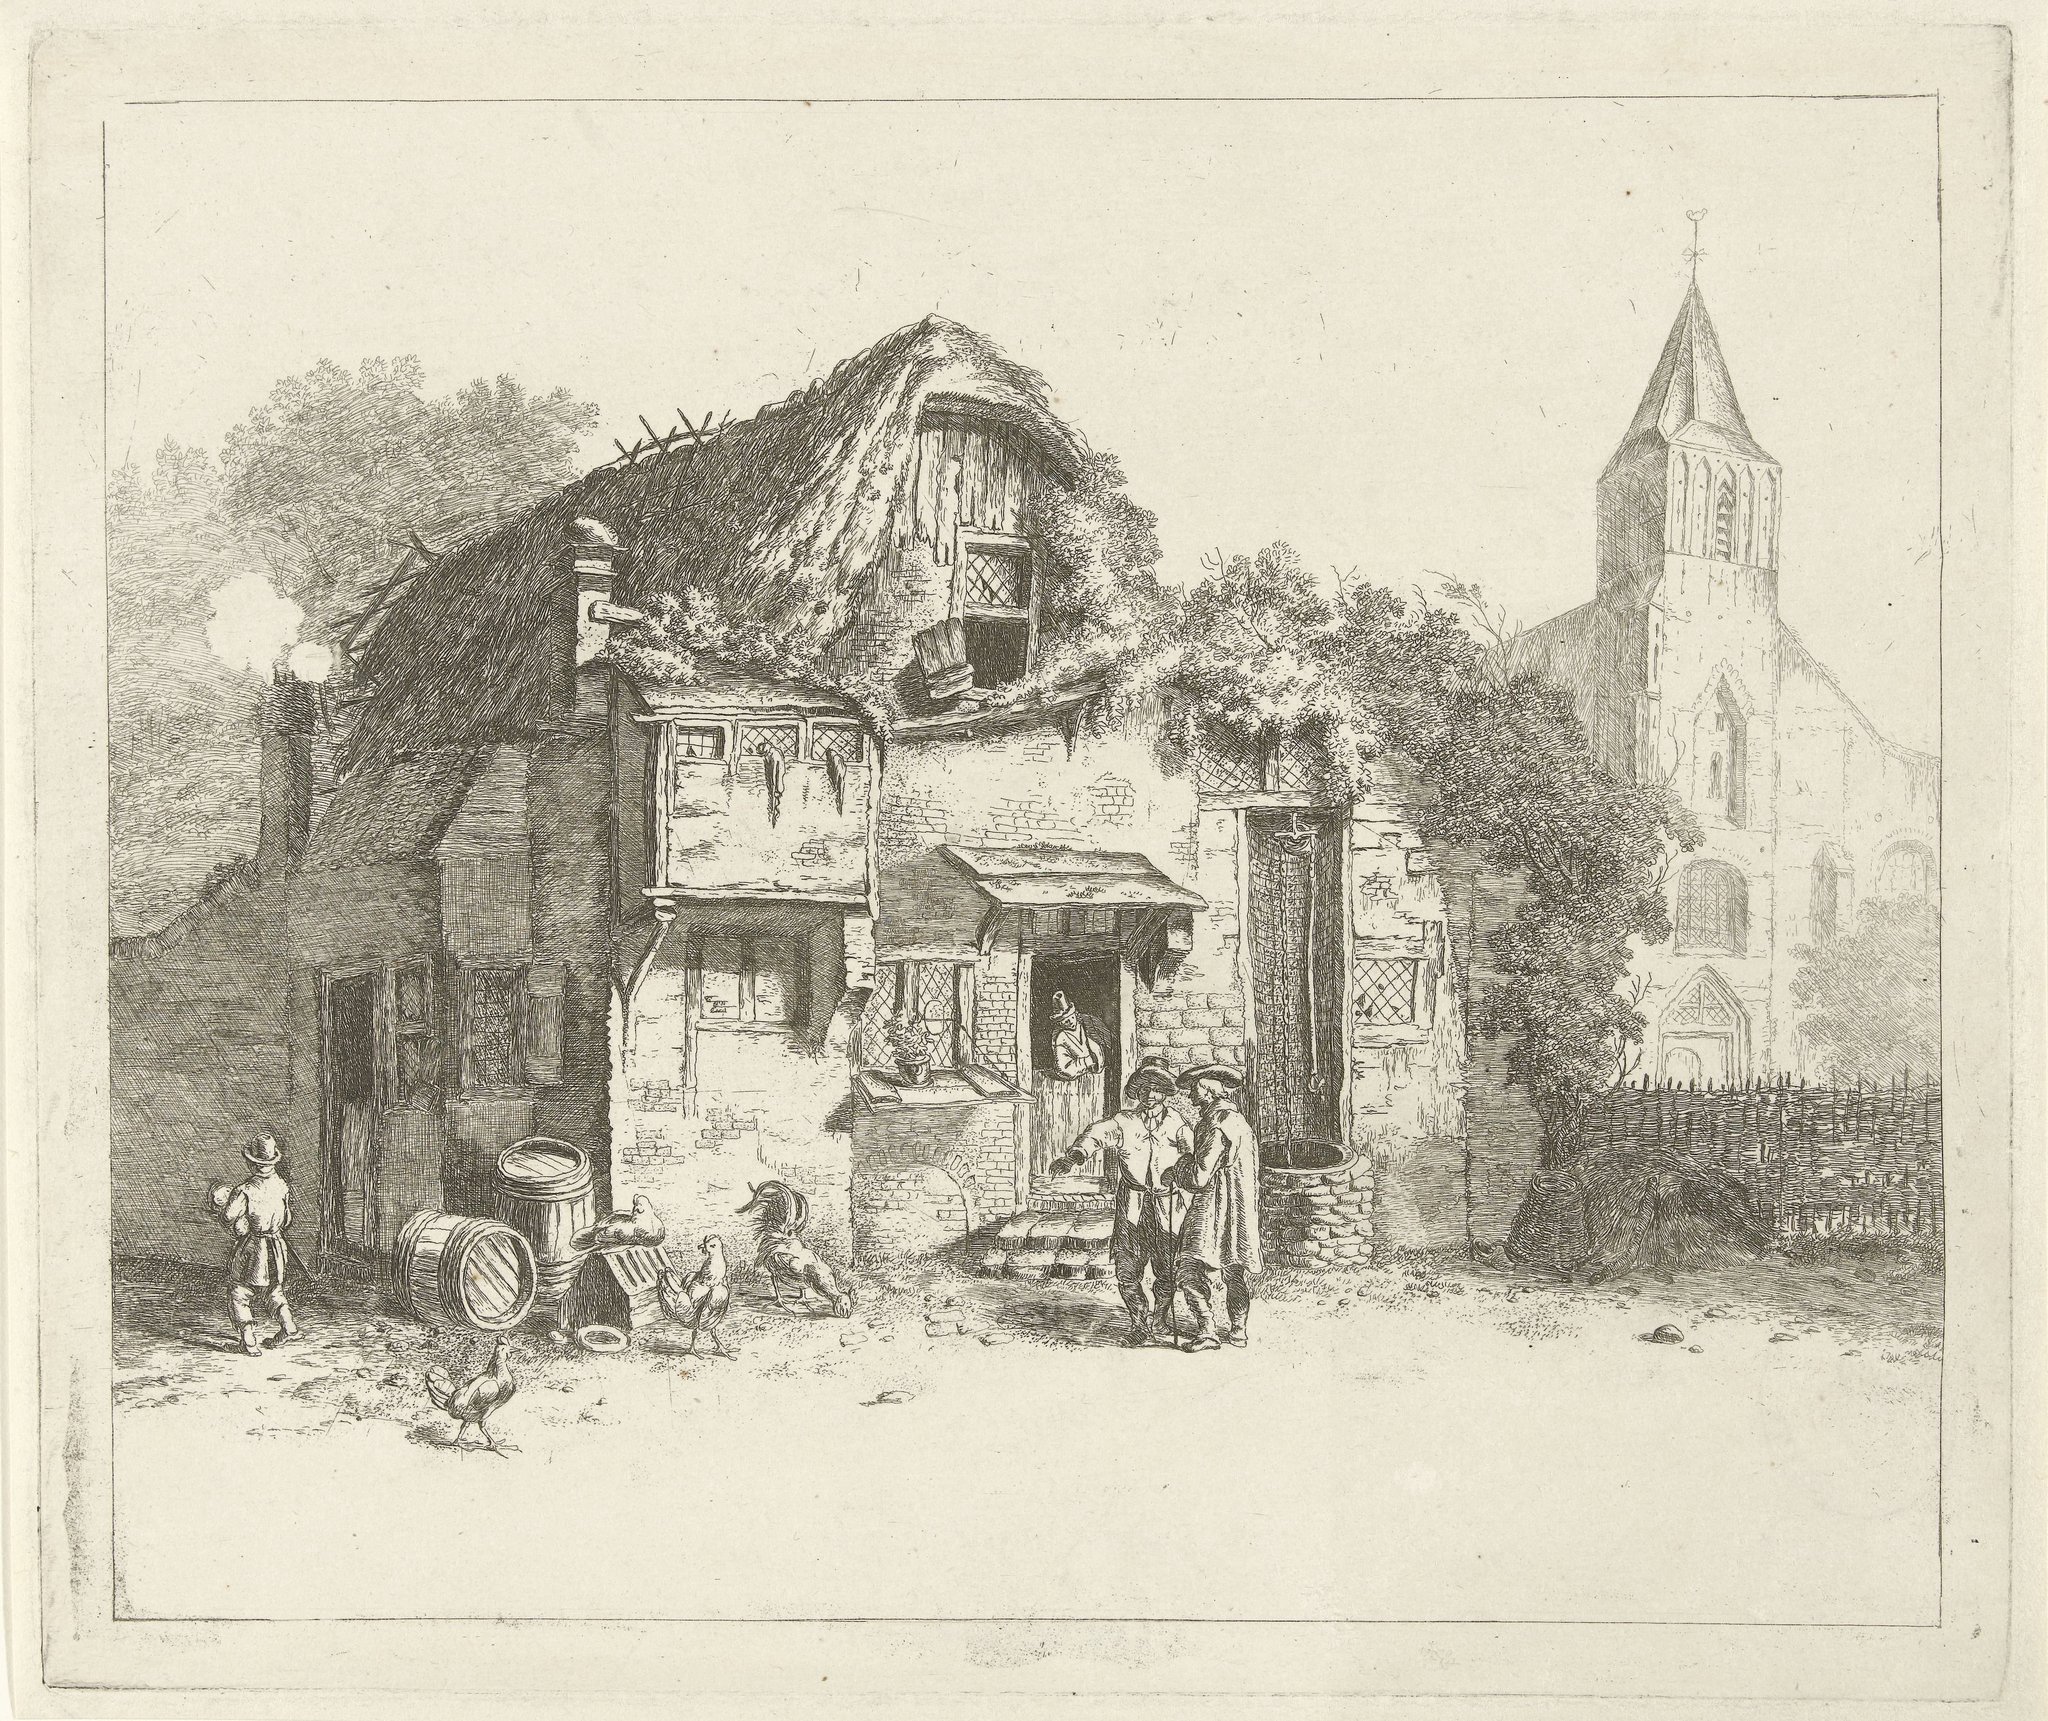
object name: print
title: Boerderij bij een kerk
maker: jabes heenck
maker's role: draughtsman, print maker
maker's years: 1752-1782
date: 1780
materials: paper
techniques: etching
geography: northern netherlands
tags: well, wooden container: barrel, cask, bucket, church (exterior), farm or solitary house in landscape (+ city(-scape) with figures, staffage)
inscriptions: collector's mark: Lugt 240